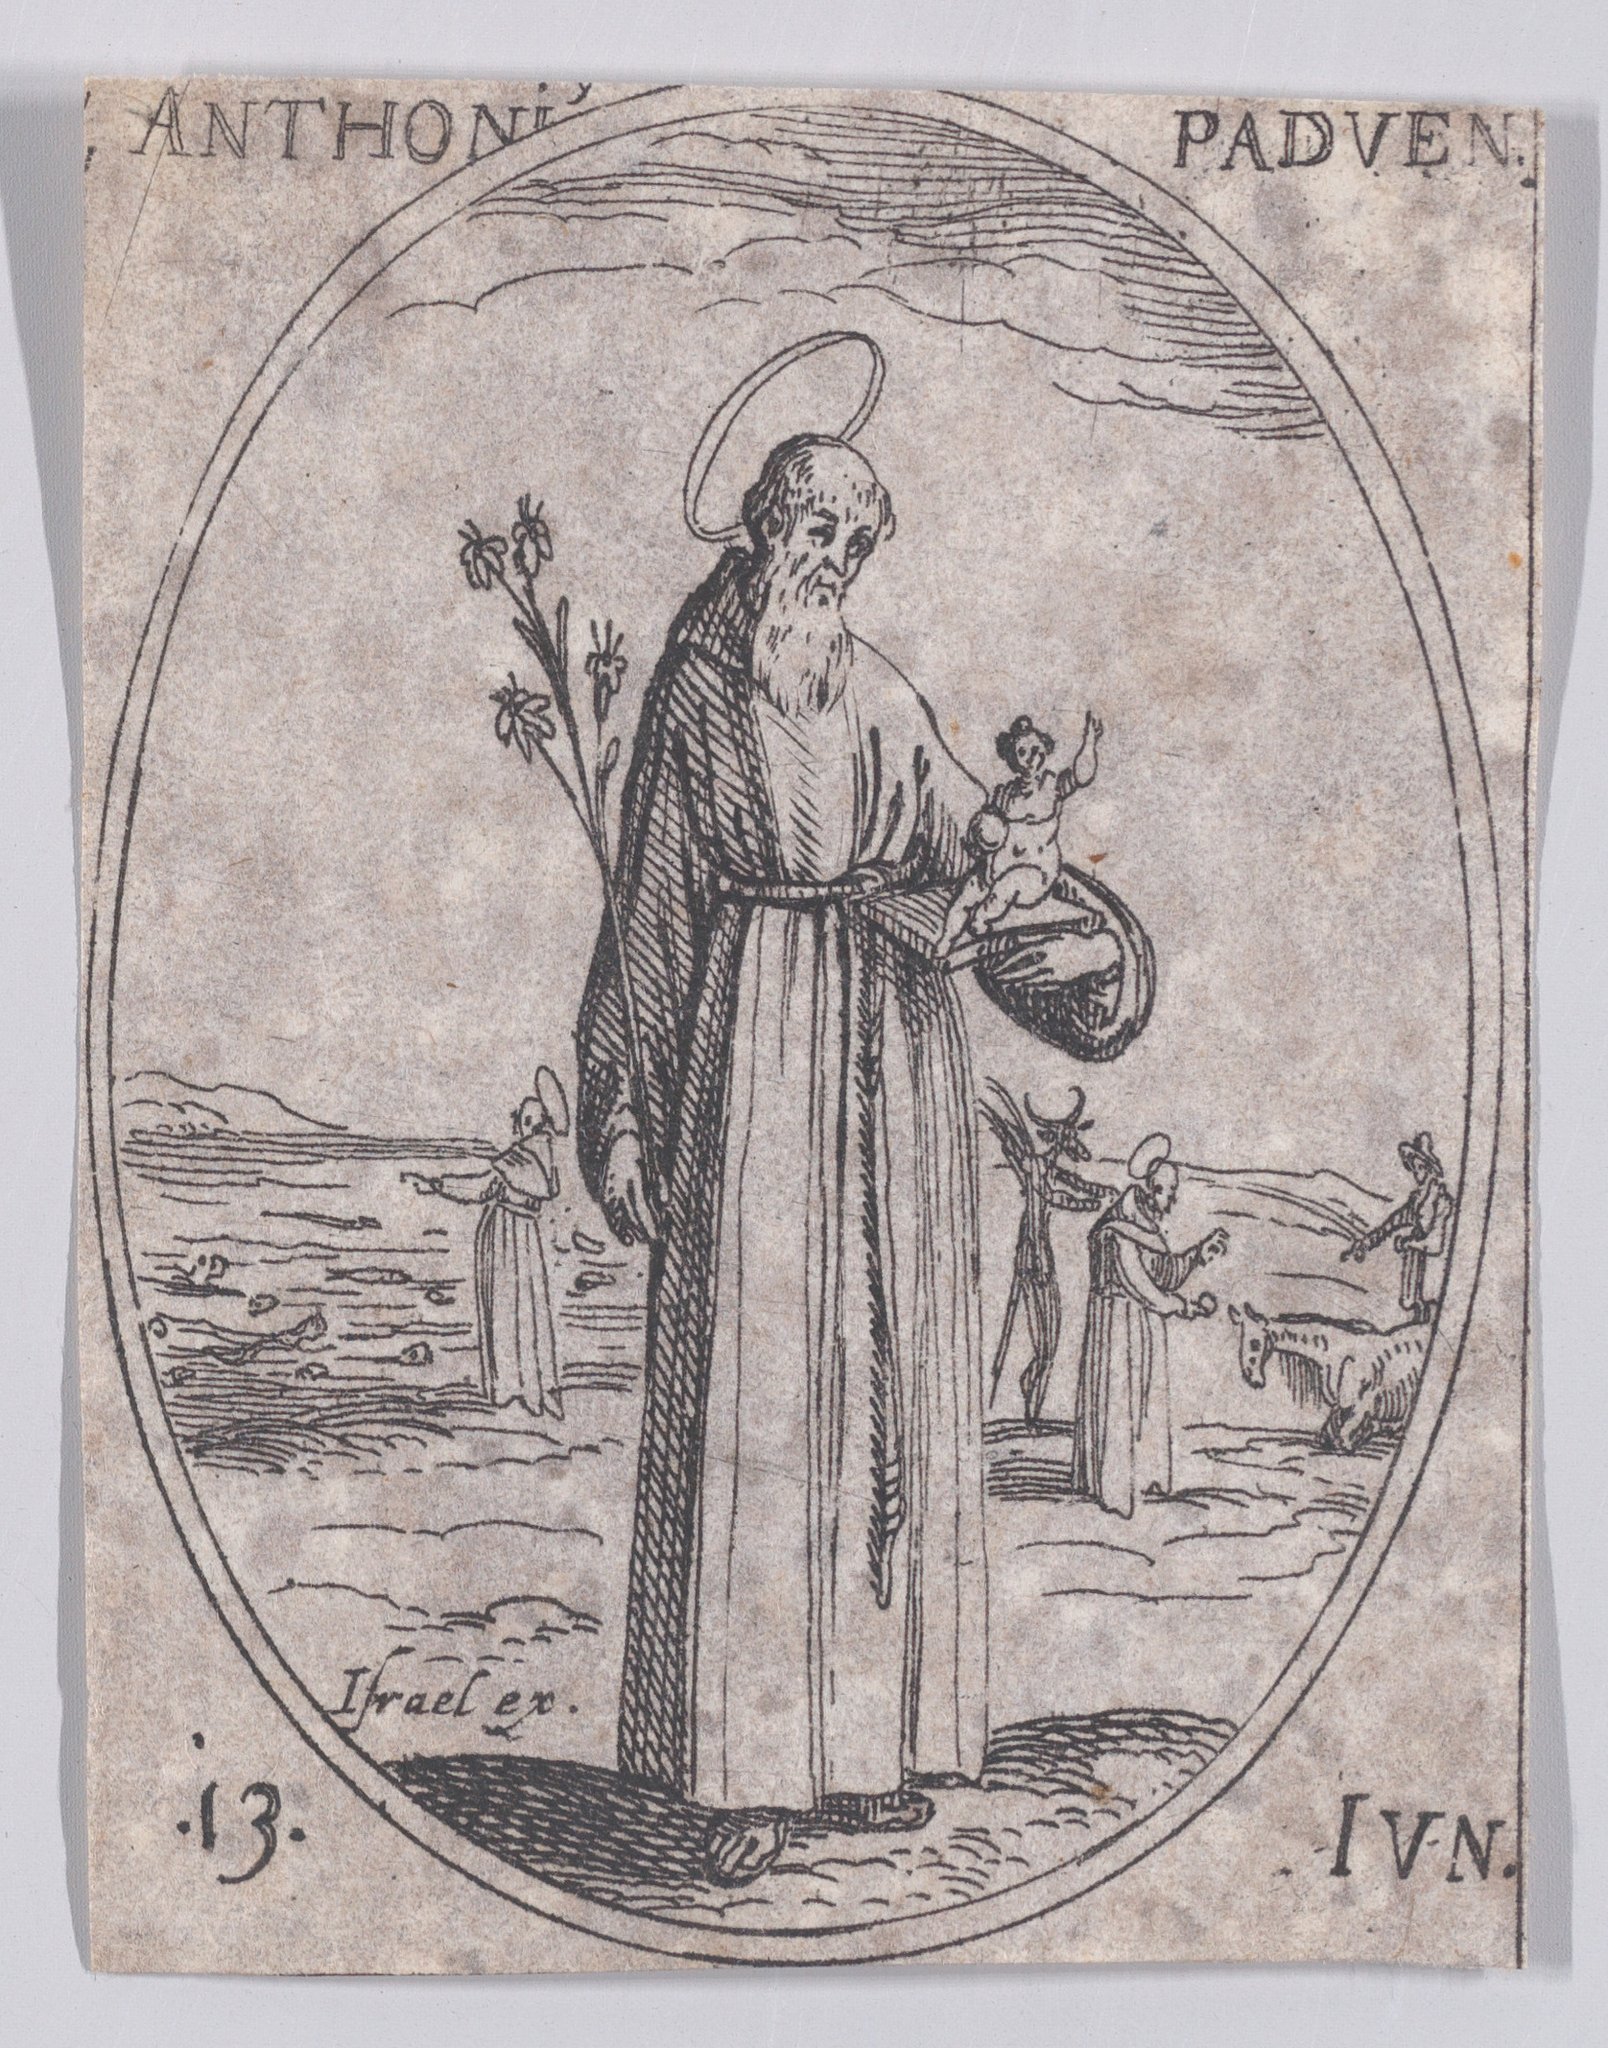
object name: print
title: S. Antoine de Padue (St. Anthony of Padua), June 13th, from "Les Images De Tous Les Saincts et Saintes de L'Année" (Images of All of the Saints and Religious Events of the Year)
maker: jacques callot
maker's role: artist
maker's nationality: french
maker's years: 1592-1635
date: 1636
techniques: etching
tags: men,saints